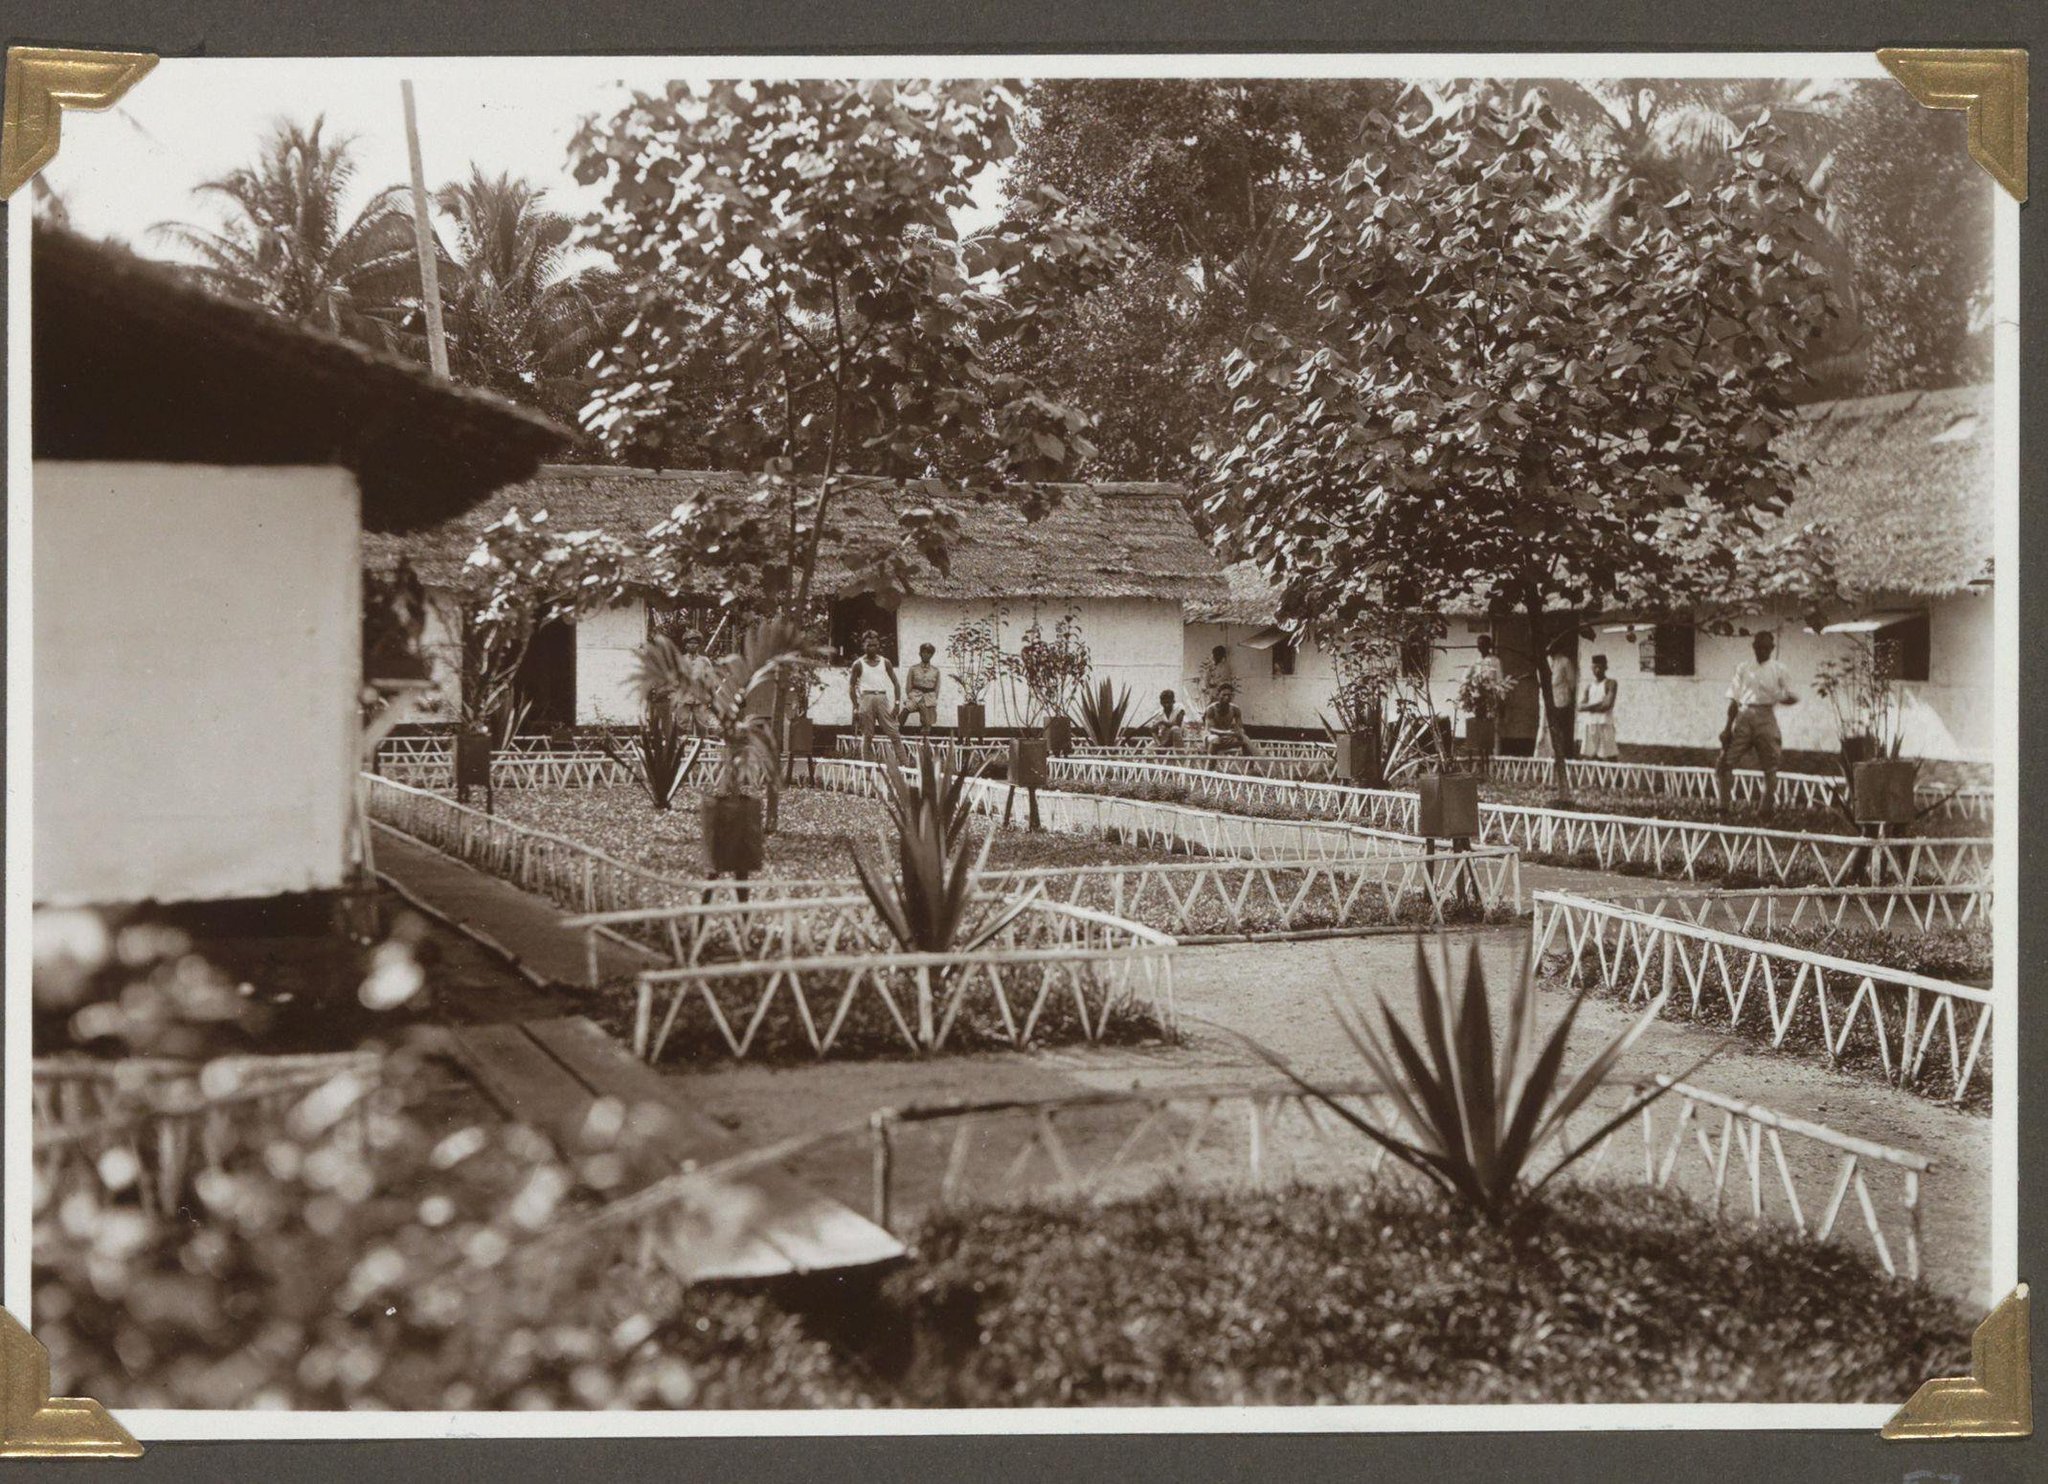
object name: photograph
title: Binnenerf van een politiekazerne in Lampong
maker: Anonymous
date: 1932-1933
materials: photographic support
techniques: gelatin silver print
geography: lampung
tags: courtyard, barracks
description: Onderdeel van Herinneringsalbum voor F.J. Junius, vertrekkend resident van Lampong (Zuid-Sumatra).